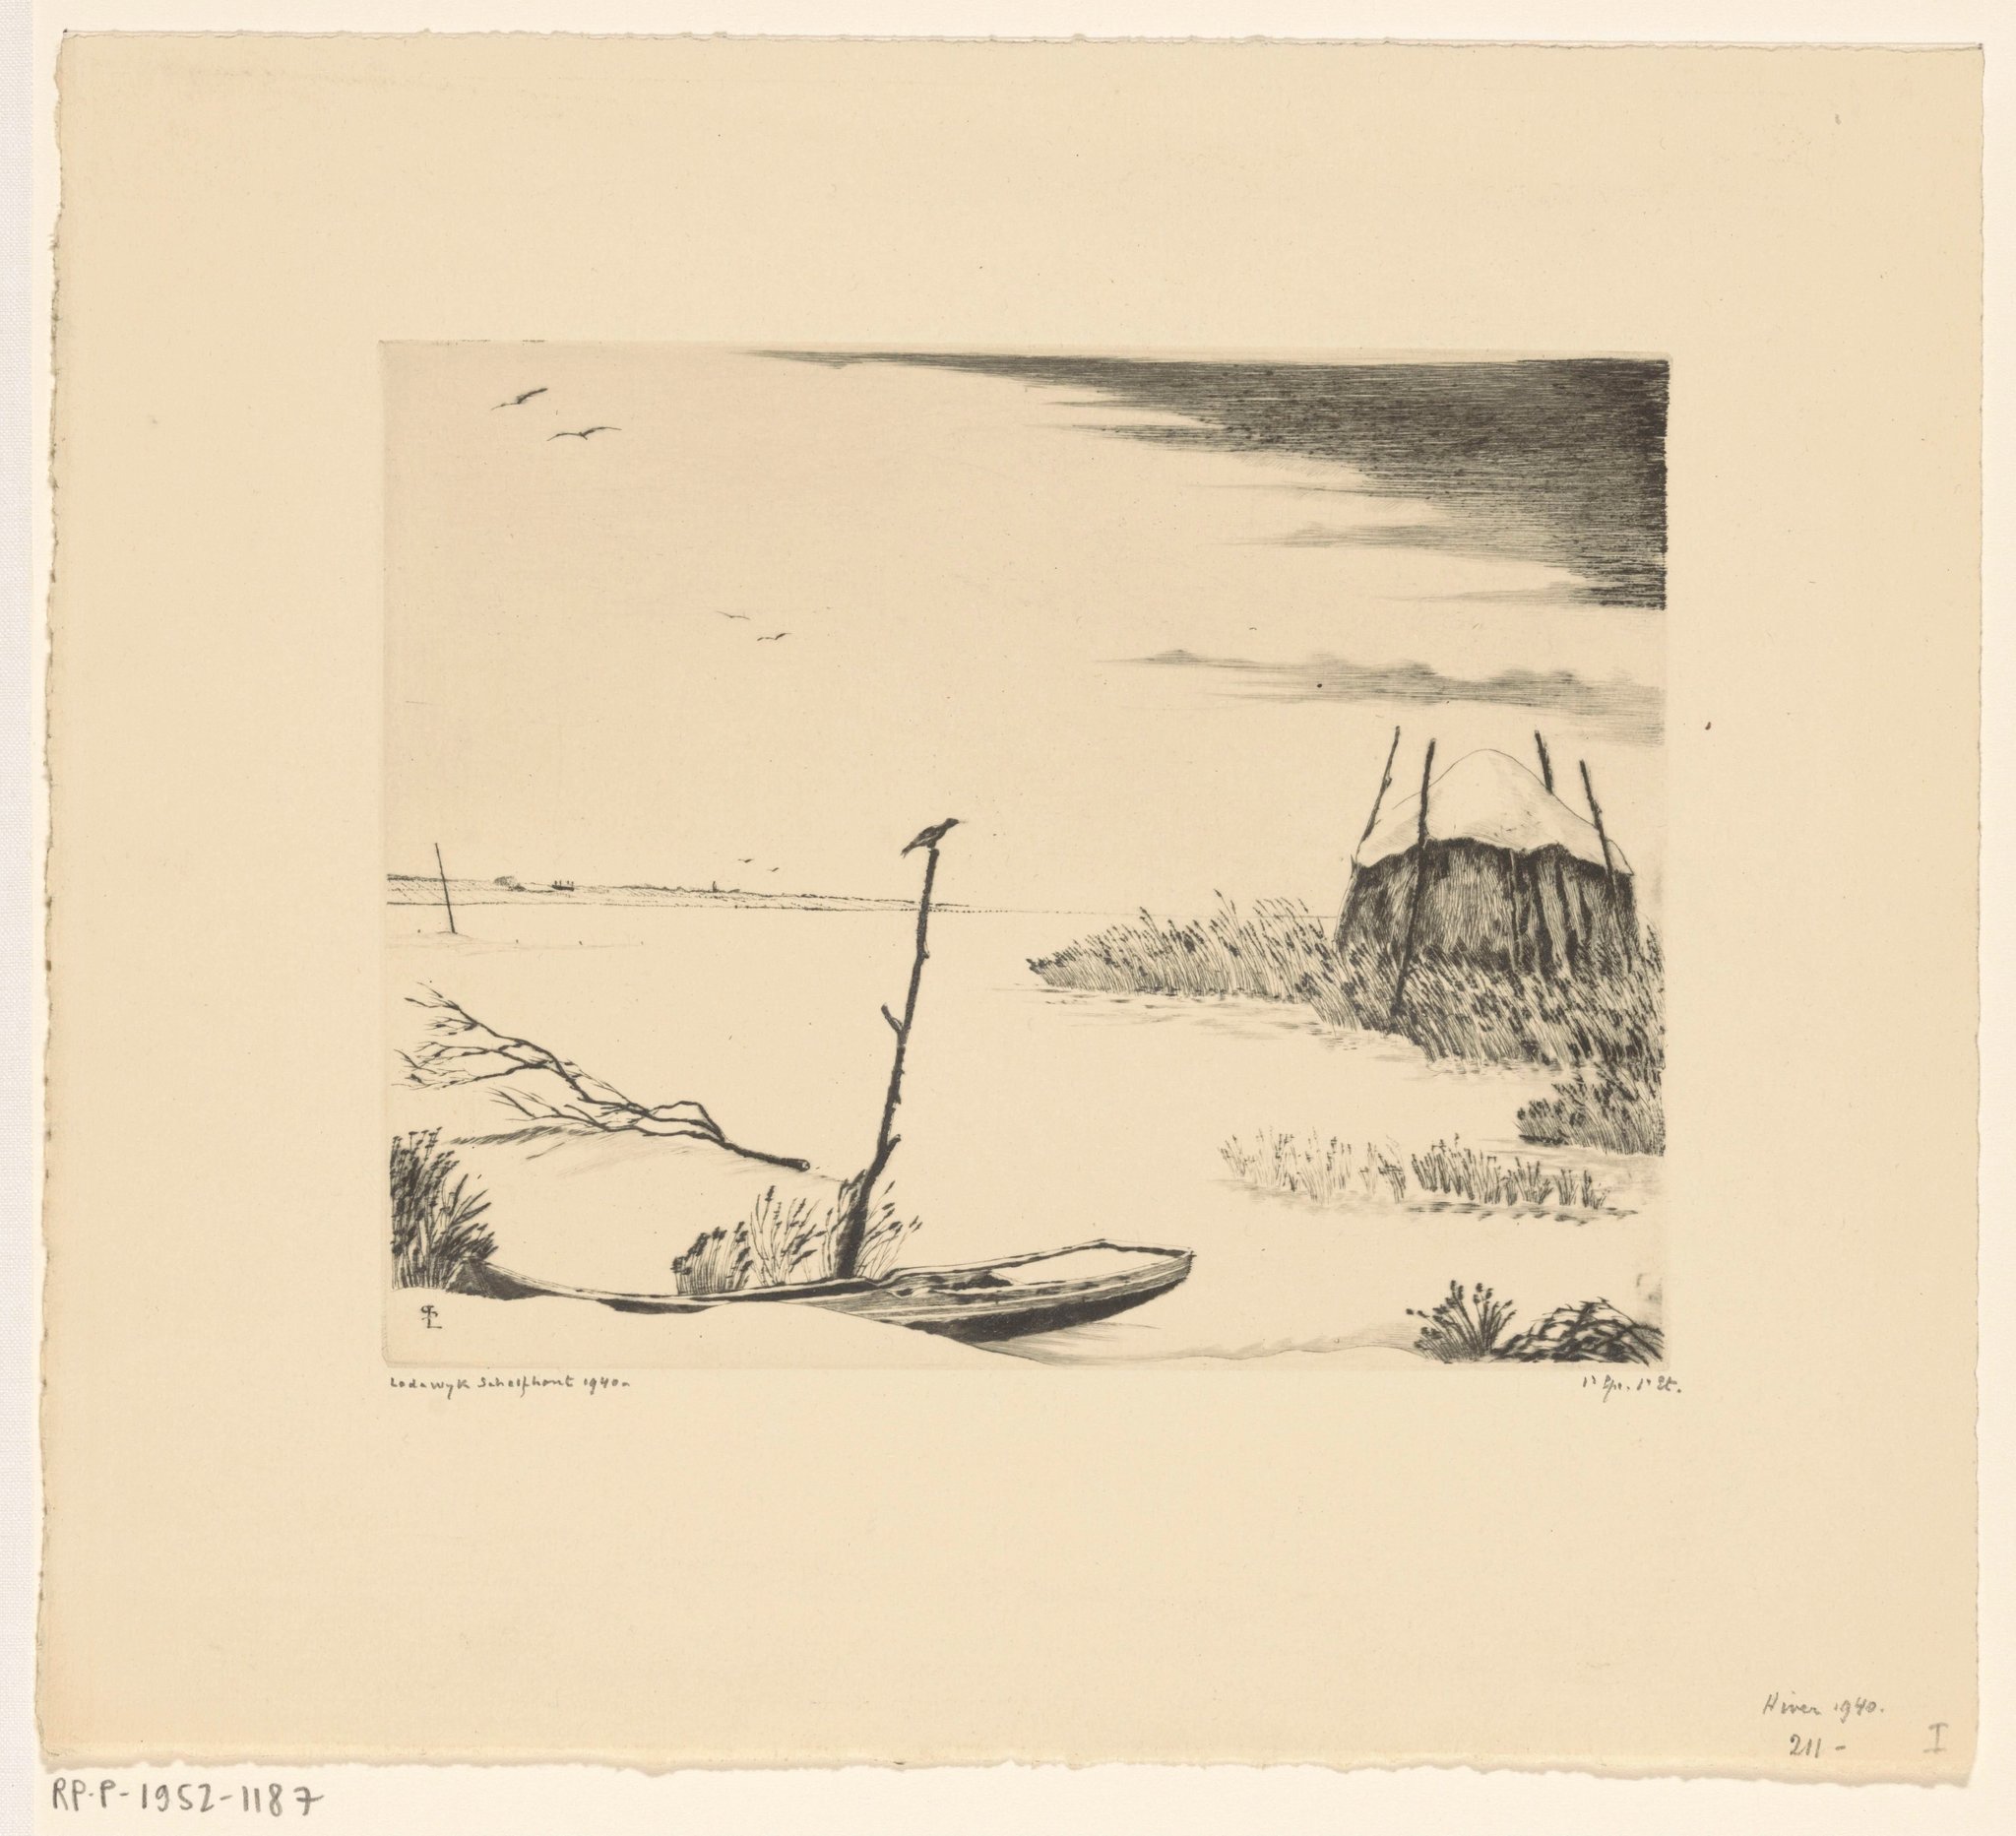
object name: print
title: Hiver 1940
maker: lodewijk schelfhout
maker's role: draughtsman, print maker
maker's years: 1881-1943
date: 1940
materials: paper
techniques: drypoint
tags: agricultural products and by-products: hay, rowing-boat, canoe, etc., winter landscape; landscape symbolizing winter (the four seasons of the year)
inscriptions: collector's mark: Lugt 2228